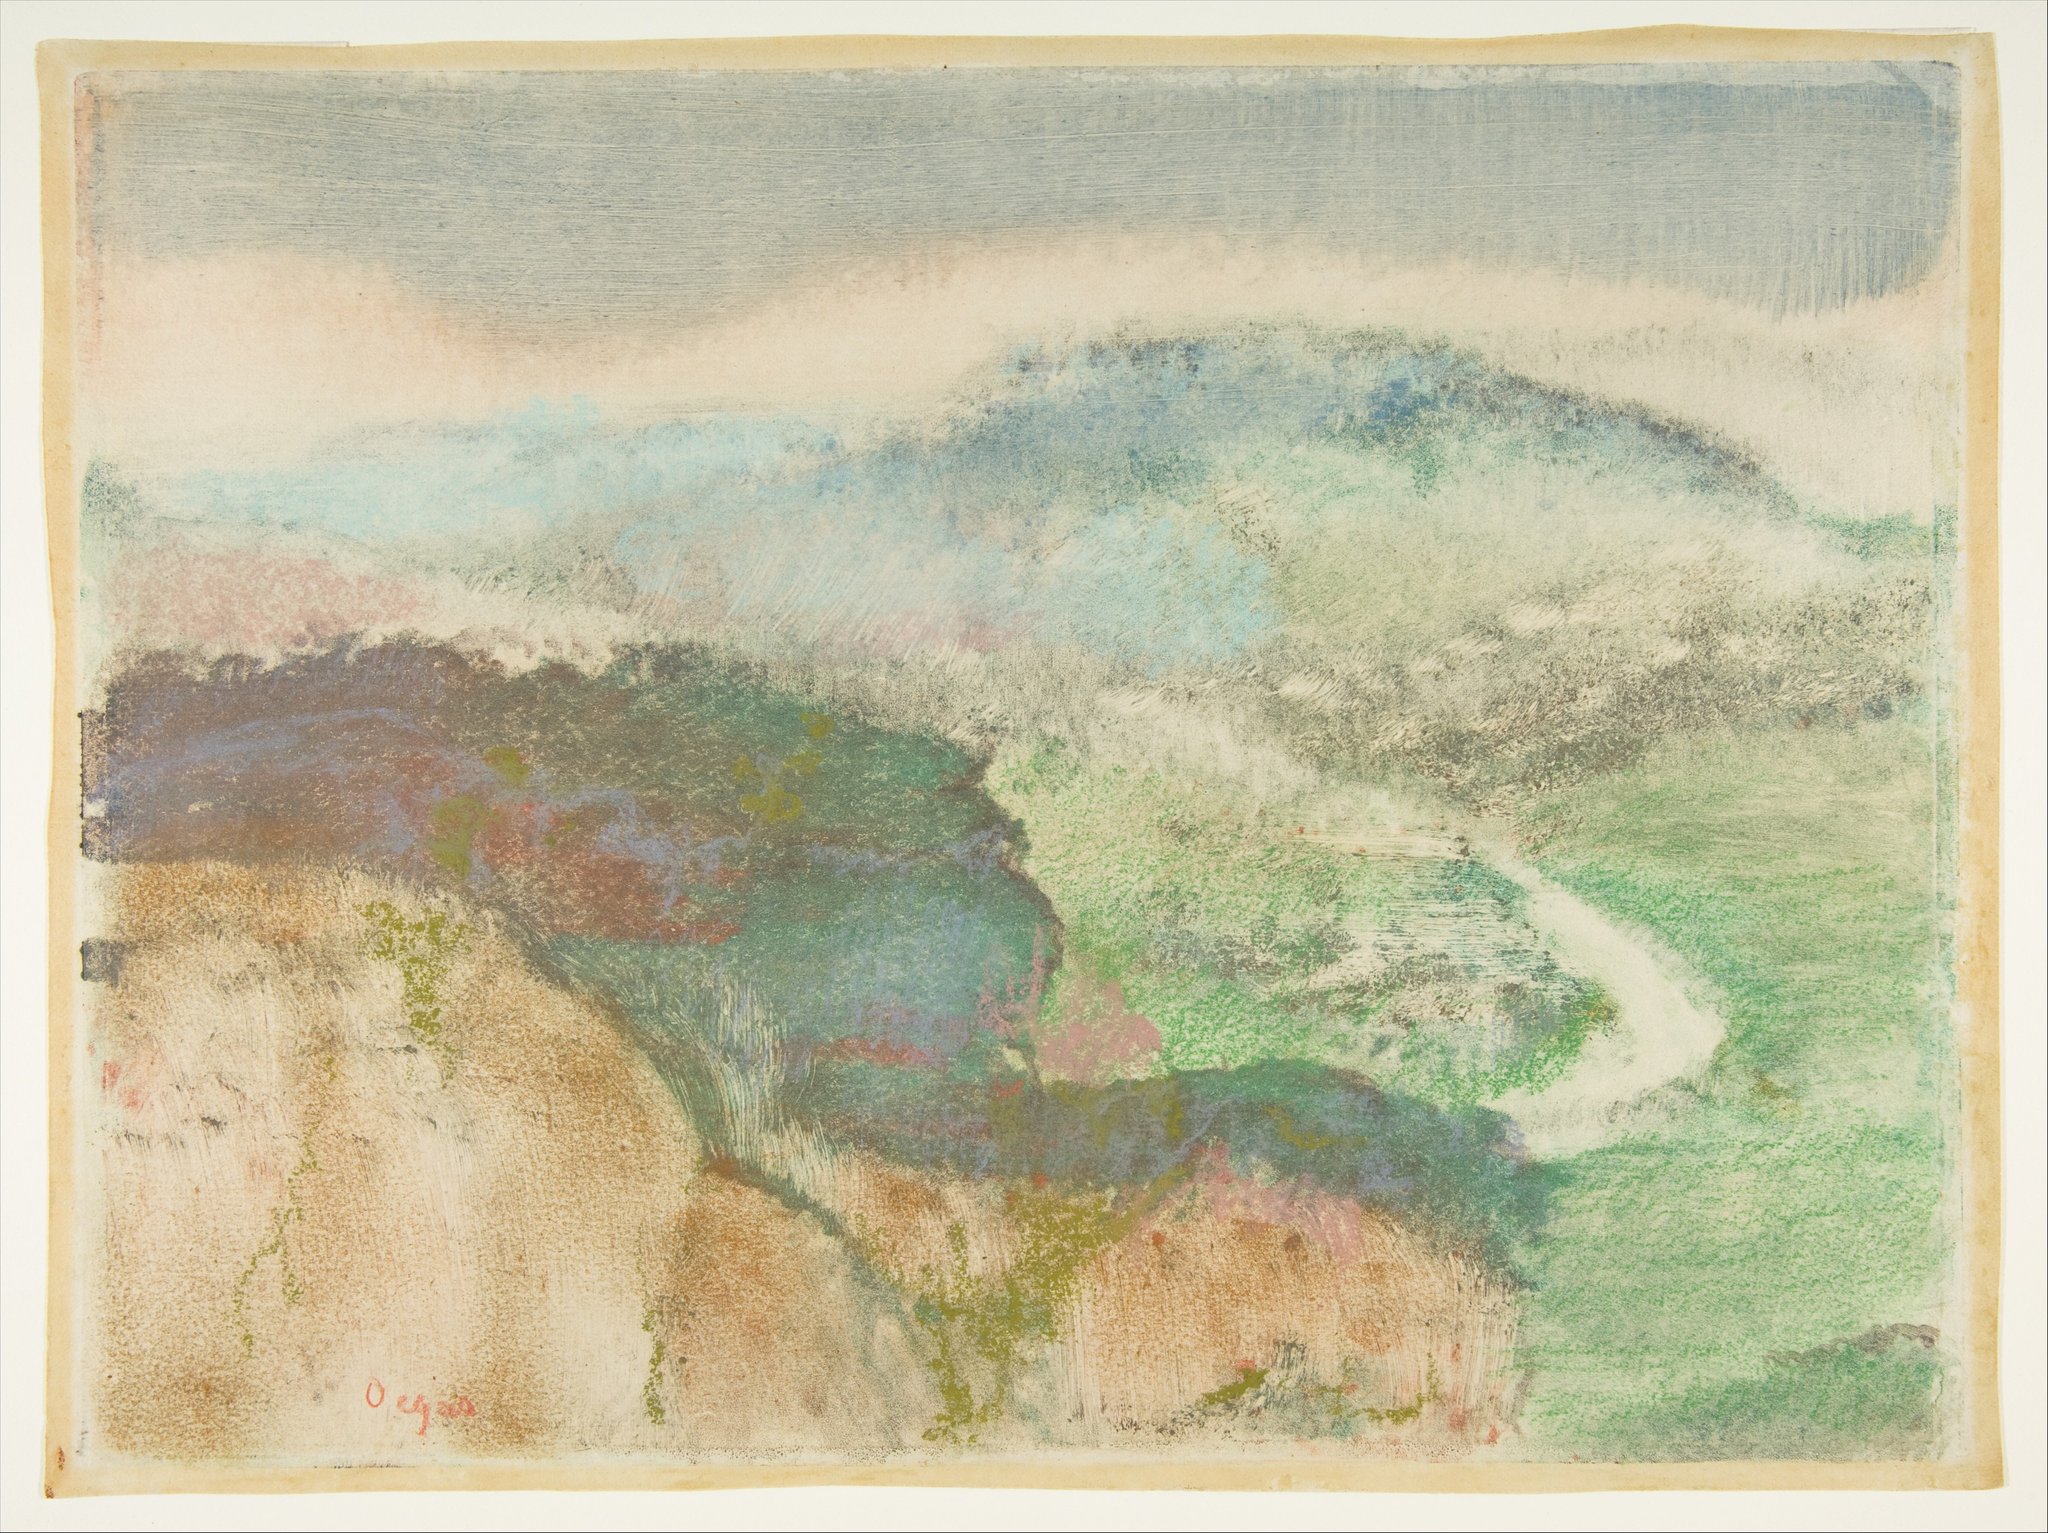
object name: print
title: Landscape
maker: edgar degas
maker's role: artist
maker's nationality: french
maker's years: 1834-1917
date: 1892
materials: oil, pastel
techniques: heightening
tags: landscapes